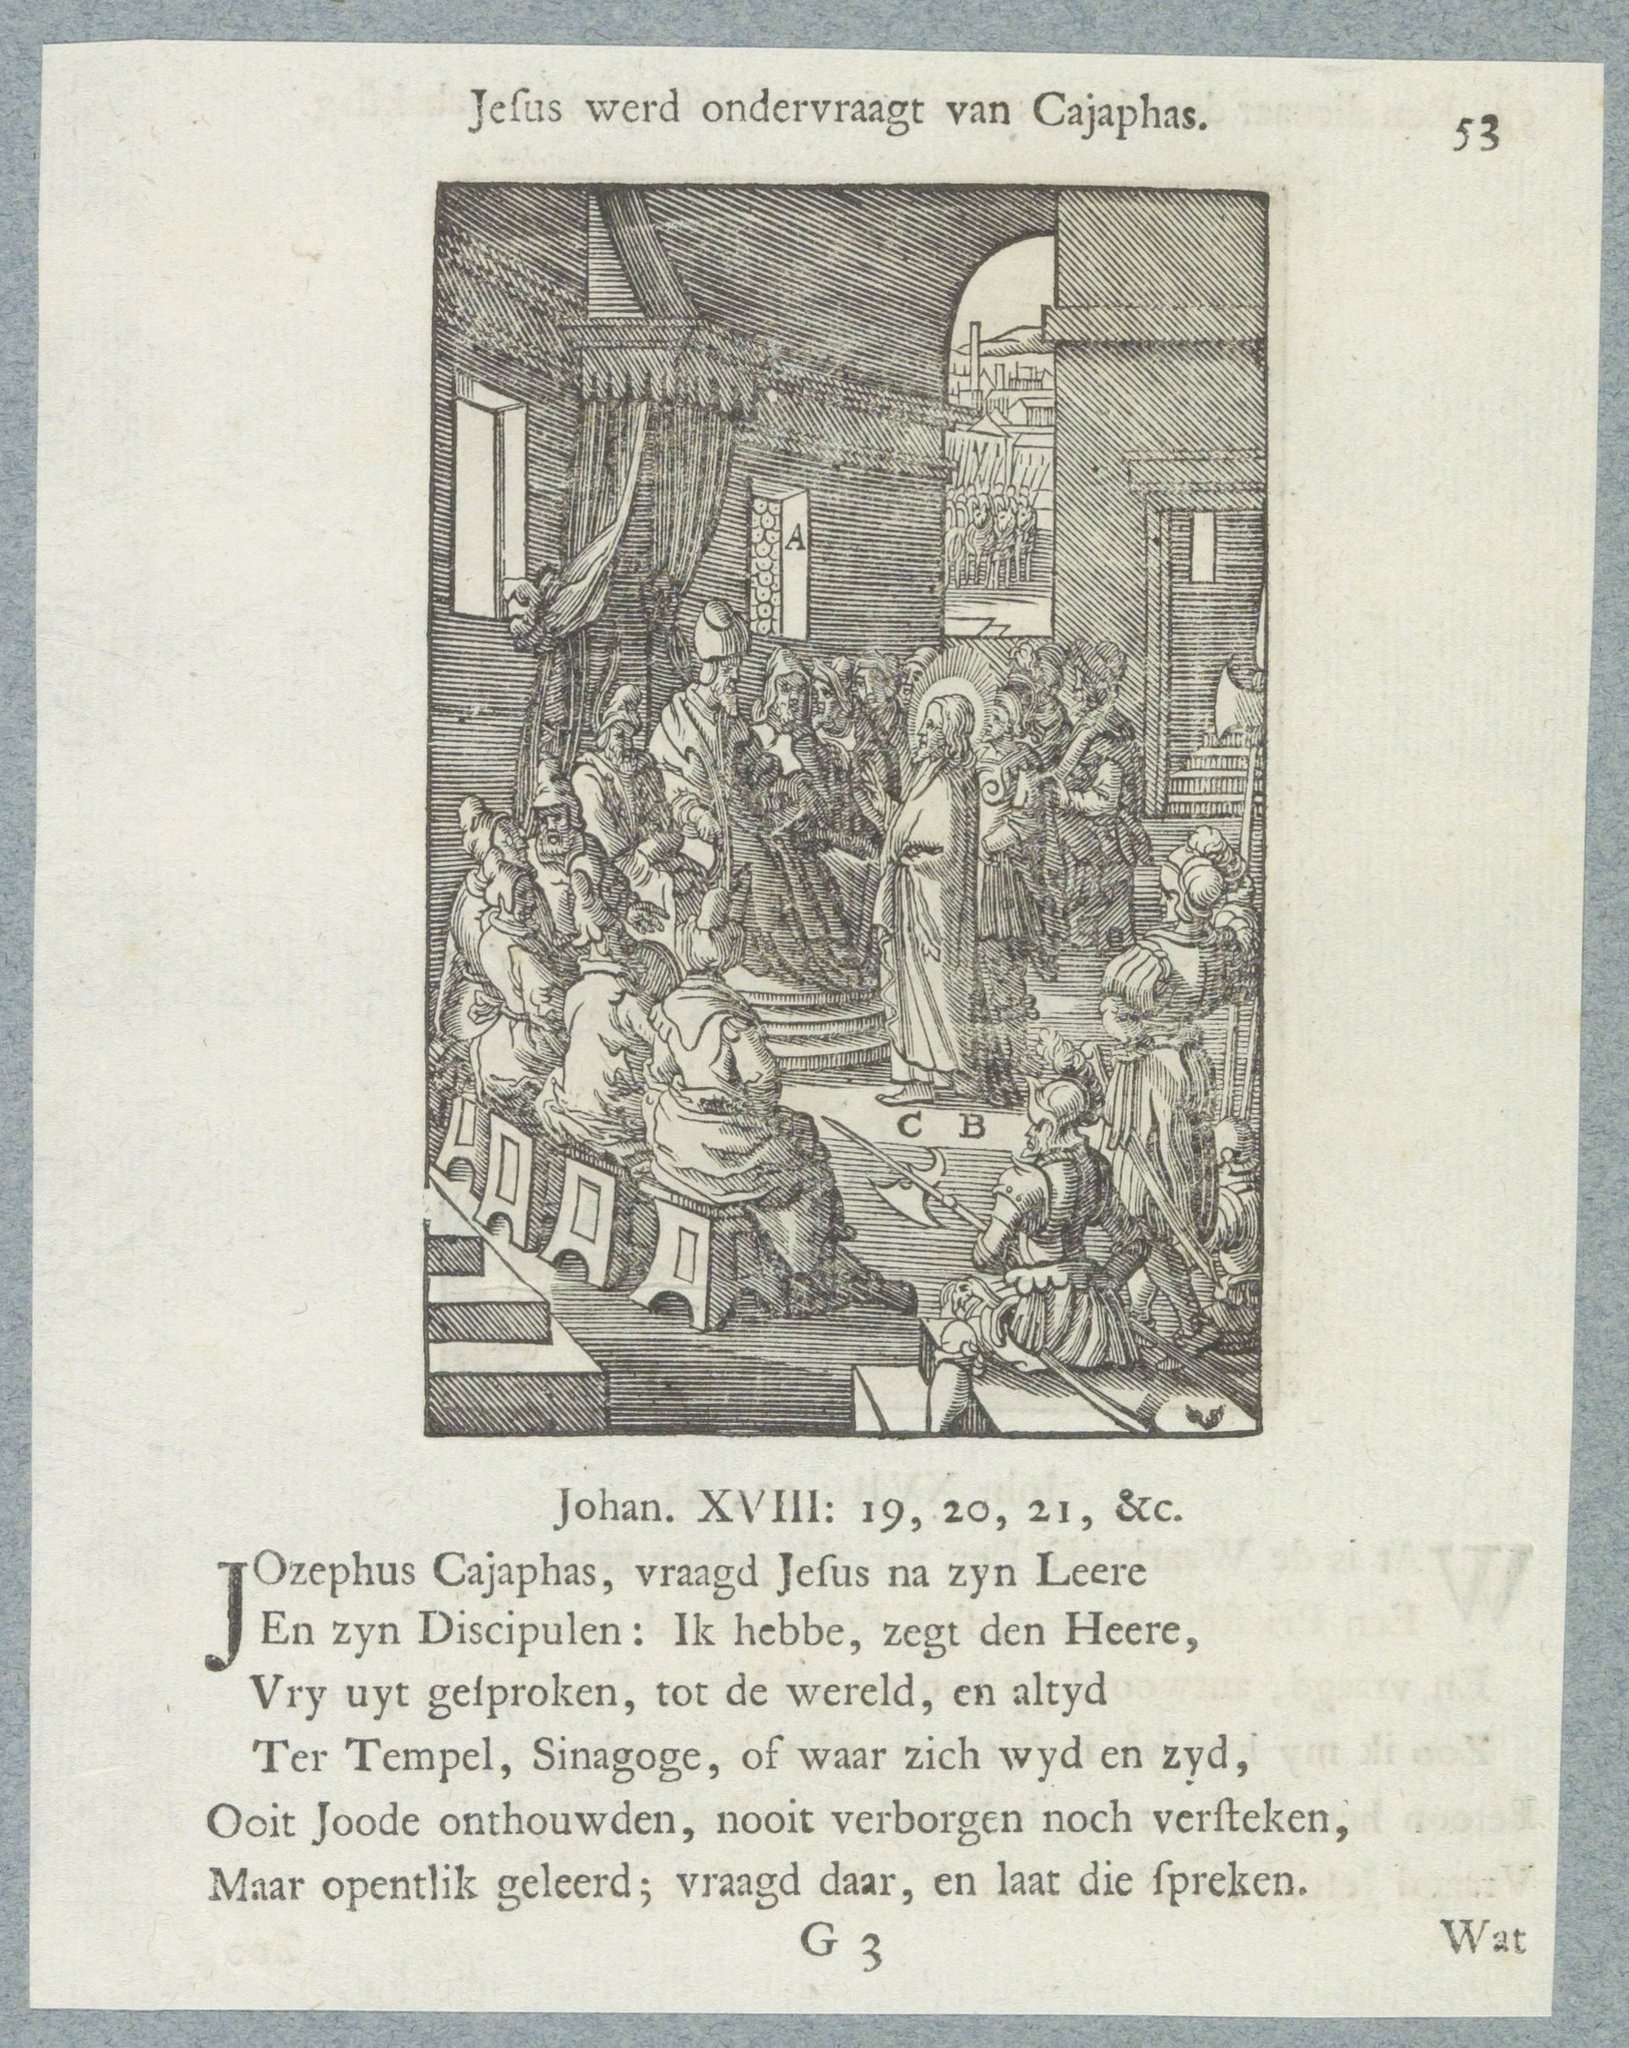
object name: album leaf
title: Christus voor het Sanhedrin en de oudsten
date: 1629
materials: paper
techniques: letterpress printing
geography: amsterdam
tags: christ before the sanhedrin with caiaphas as high priest, and possibly annas; maybe a soldier about to strike christ because he keeps silent (matthew 26:57-66; mark 14:53-64; luke 22:54, 22:66-71)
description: De prent is afkomstig uit: Bybels Lusthof. Amsterdam, J. Klooster, 1740. De prent werd gemaakt voor de uitgaven van P.J. Paets uit Amsterdam, verschenen in de jaren 1629-1648. Ze komt voor het eerst voor in: Der Zielen Lust-hof. Leuven, I.Jacbosz voor P.J. Paets [= Amsterdam, P.J. Paets], 1629. De voorstelling is gekopieerd naar een prent van Hieronymus Wierix voor: Nadal, Jerónimo. Evangelicae Historiae Imagines. Antwerpen, M. Nutius, 1593.